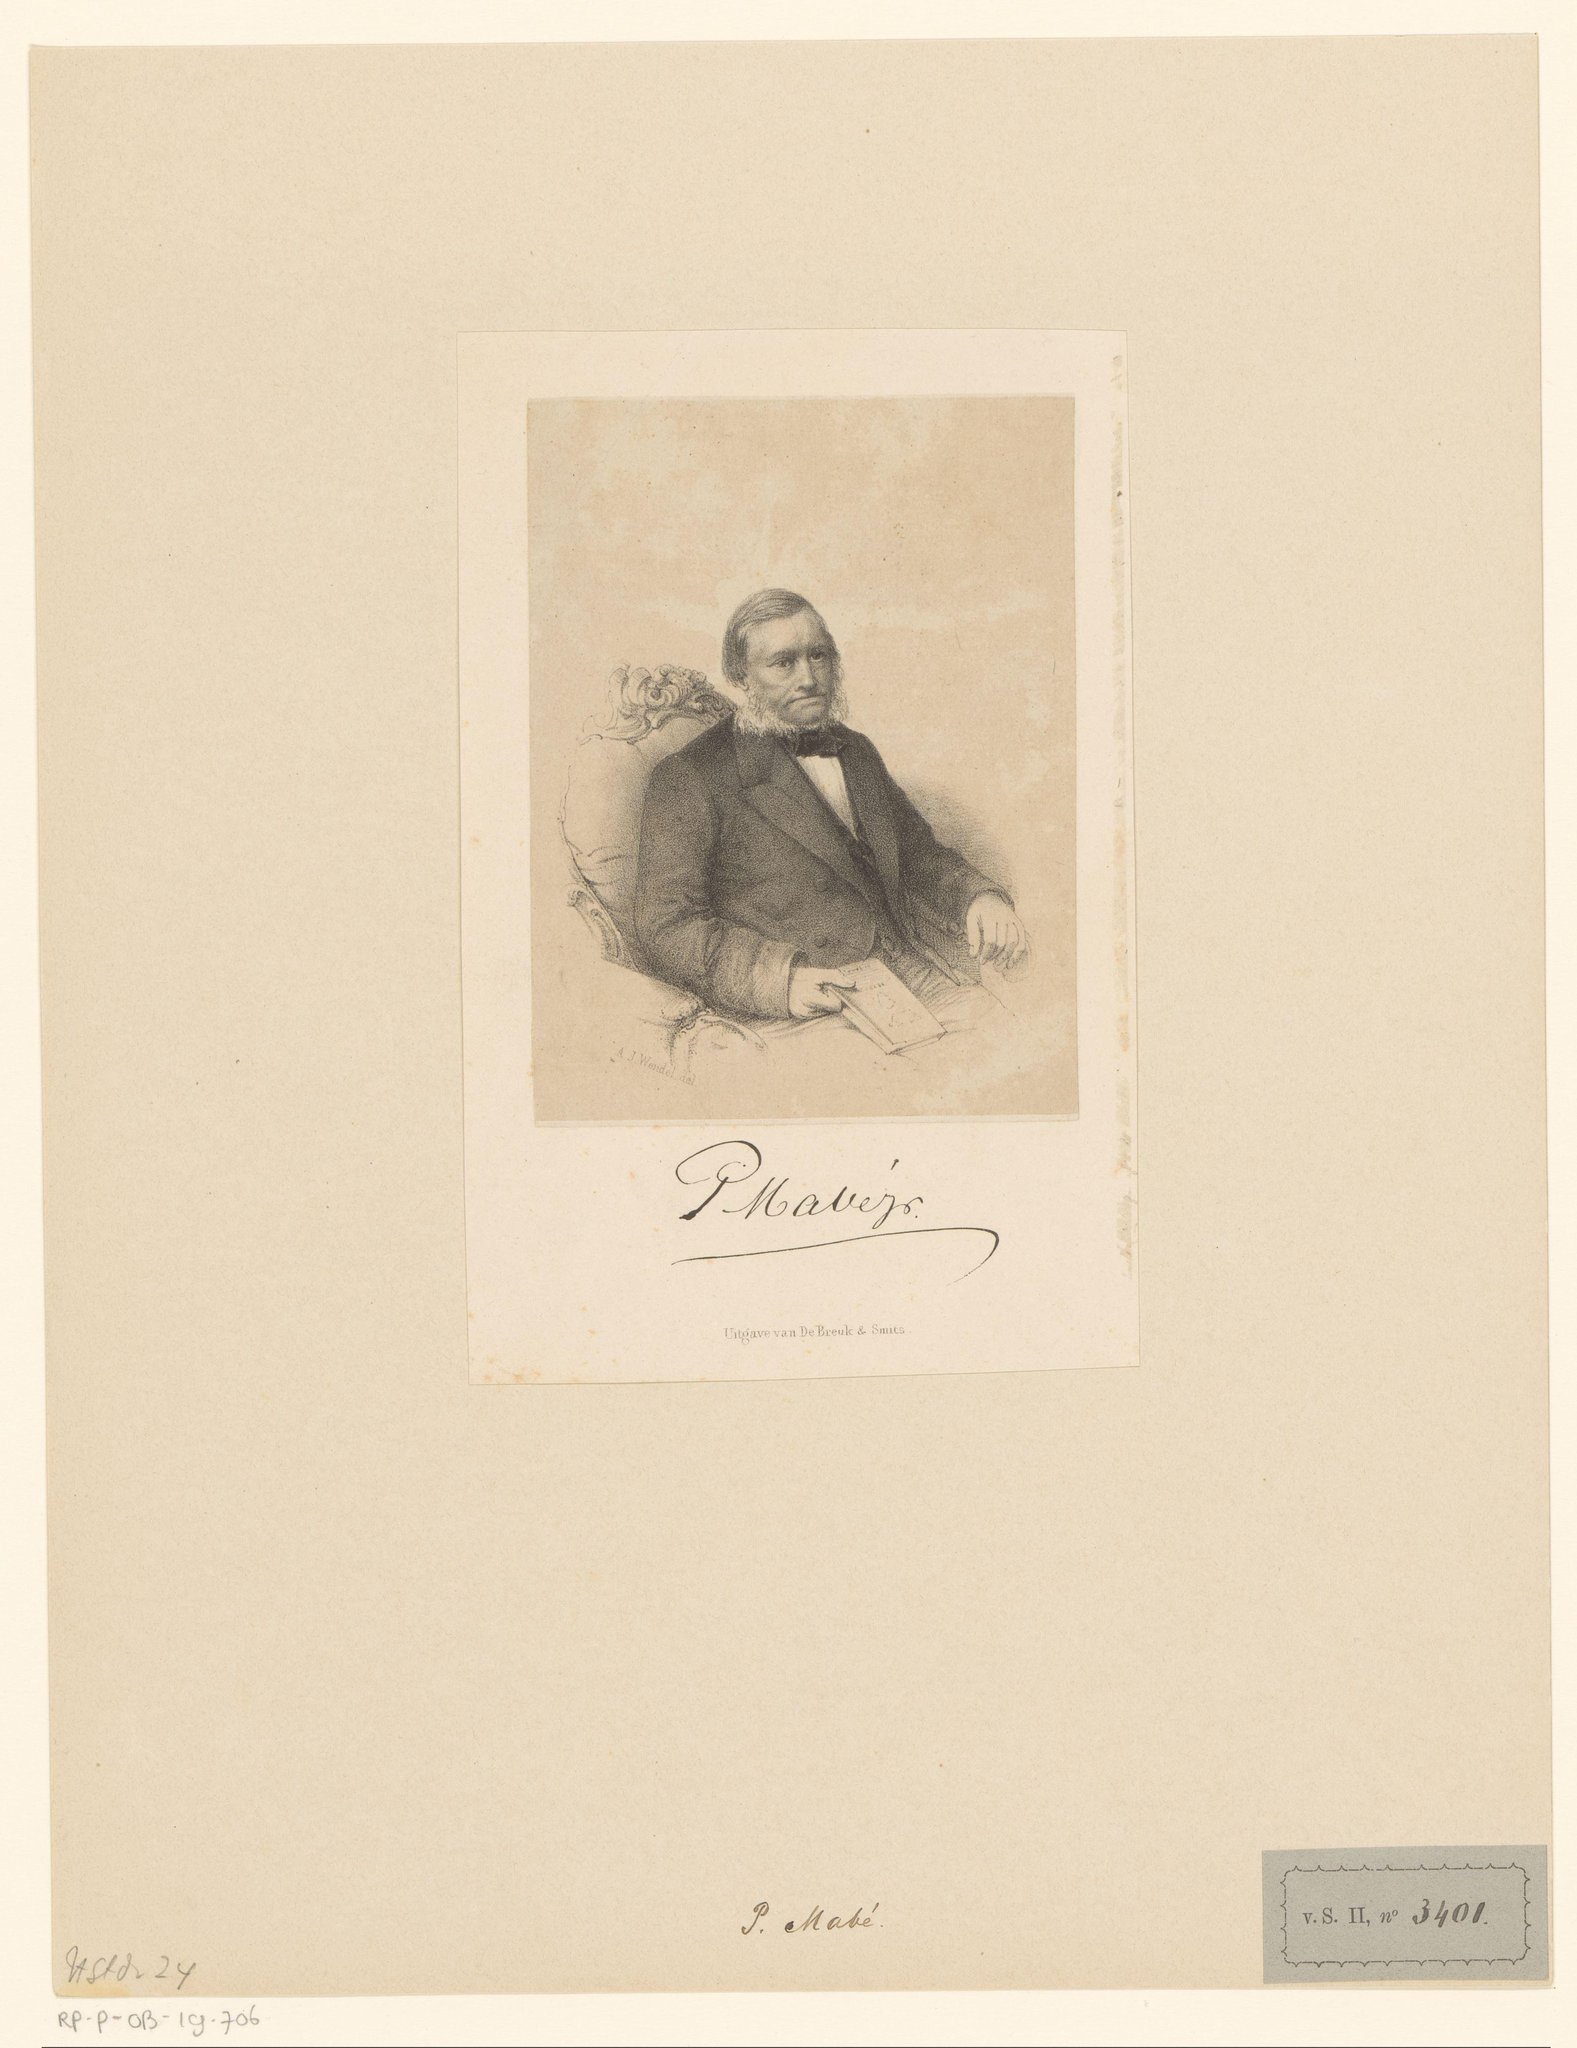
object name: print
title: Portret van P. Mabé Jr.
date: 1867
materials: paper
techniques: tone lithography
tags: historical persons (+ half-length portrait)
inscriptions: collector's mark: Lugt 2228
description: Onder het portret de signatuur van de geportretteerde.